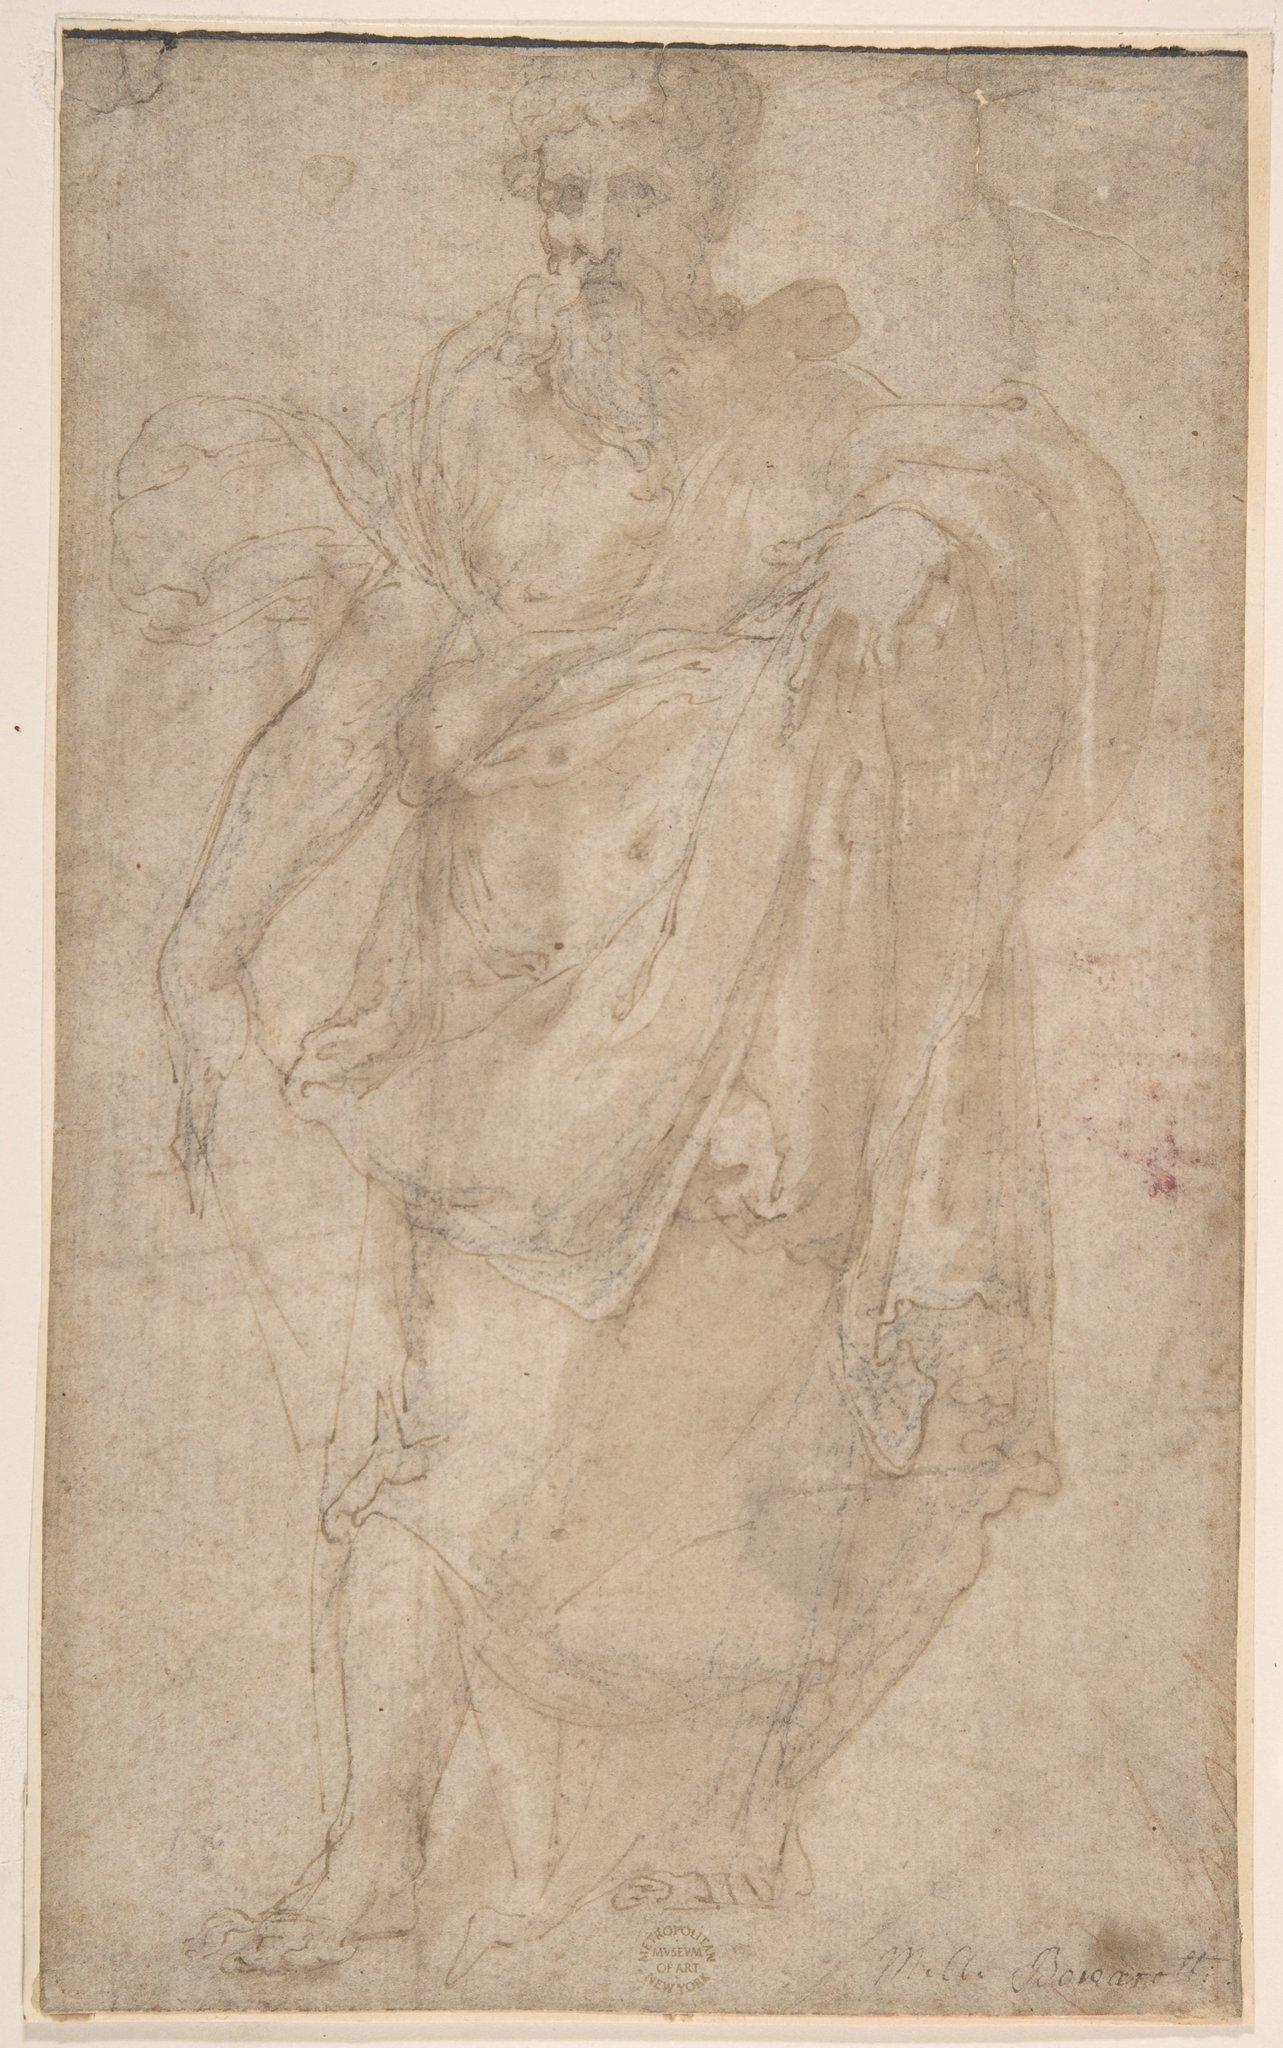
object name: drawing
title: Figure of a Prophet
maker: anonymous, italian, 16th century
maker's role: artist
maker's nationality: italian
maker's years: 1550-1600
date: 1501-1600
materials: chalk, ink, paper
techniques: brush, pen, wash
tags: men